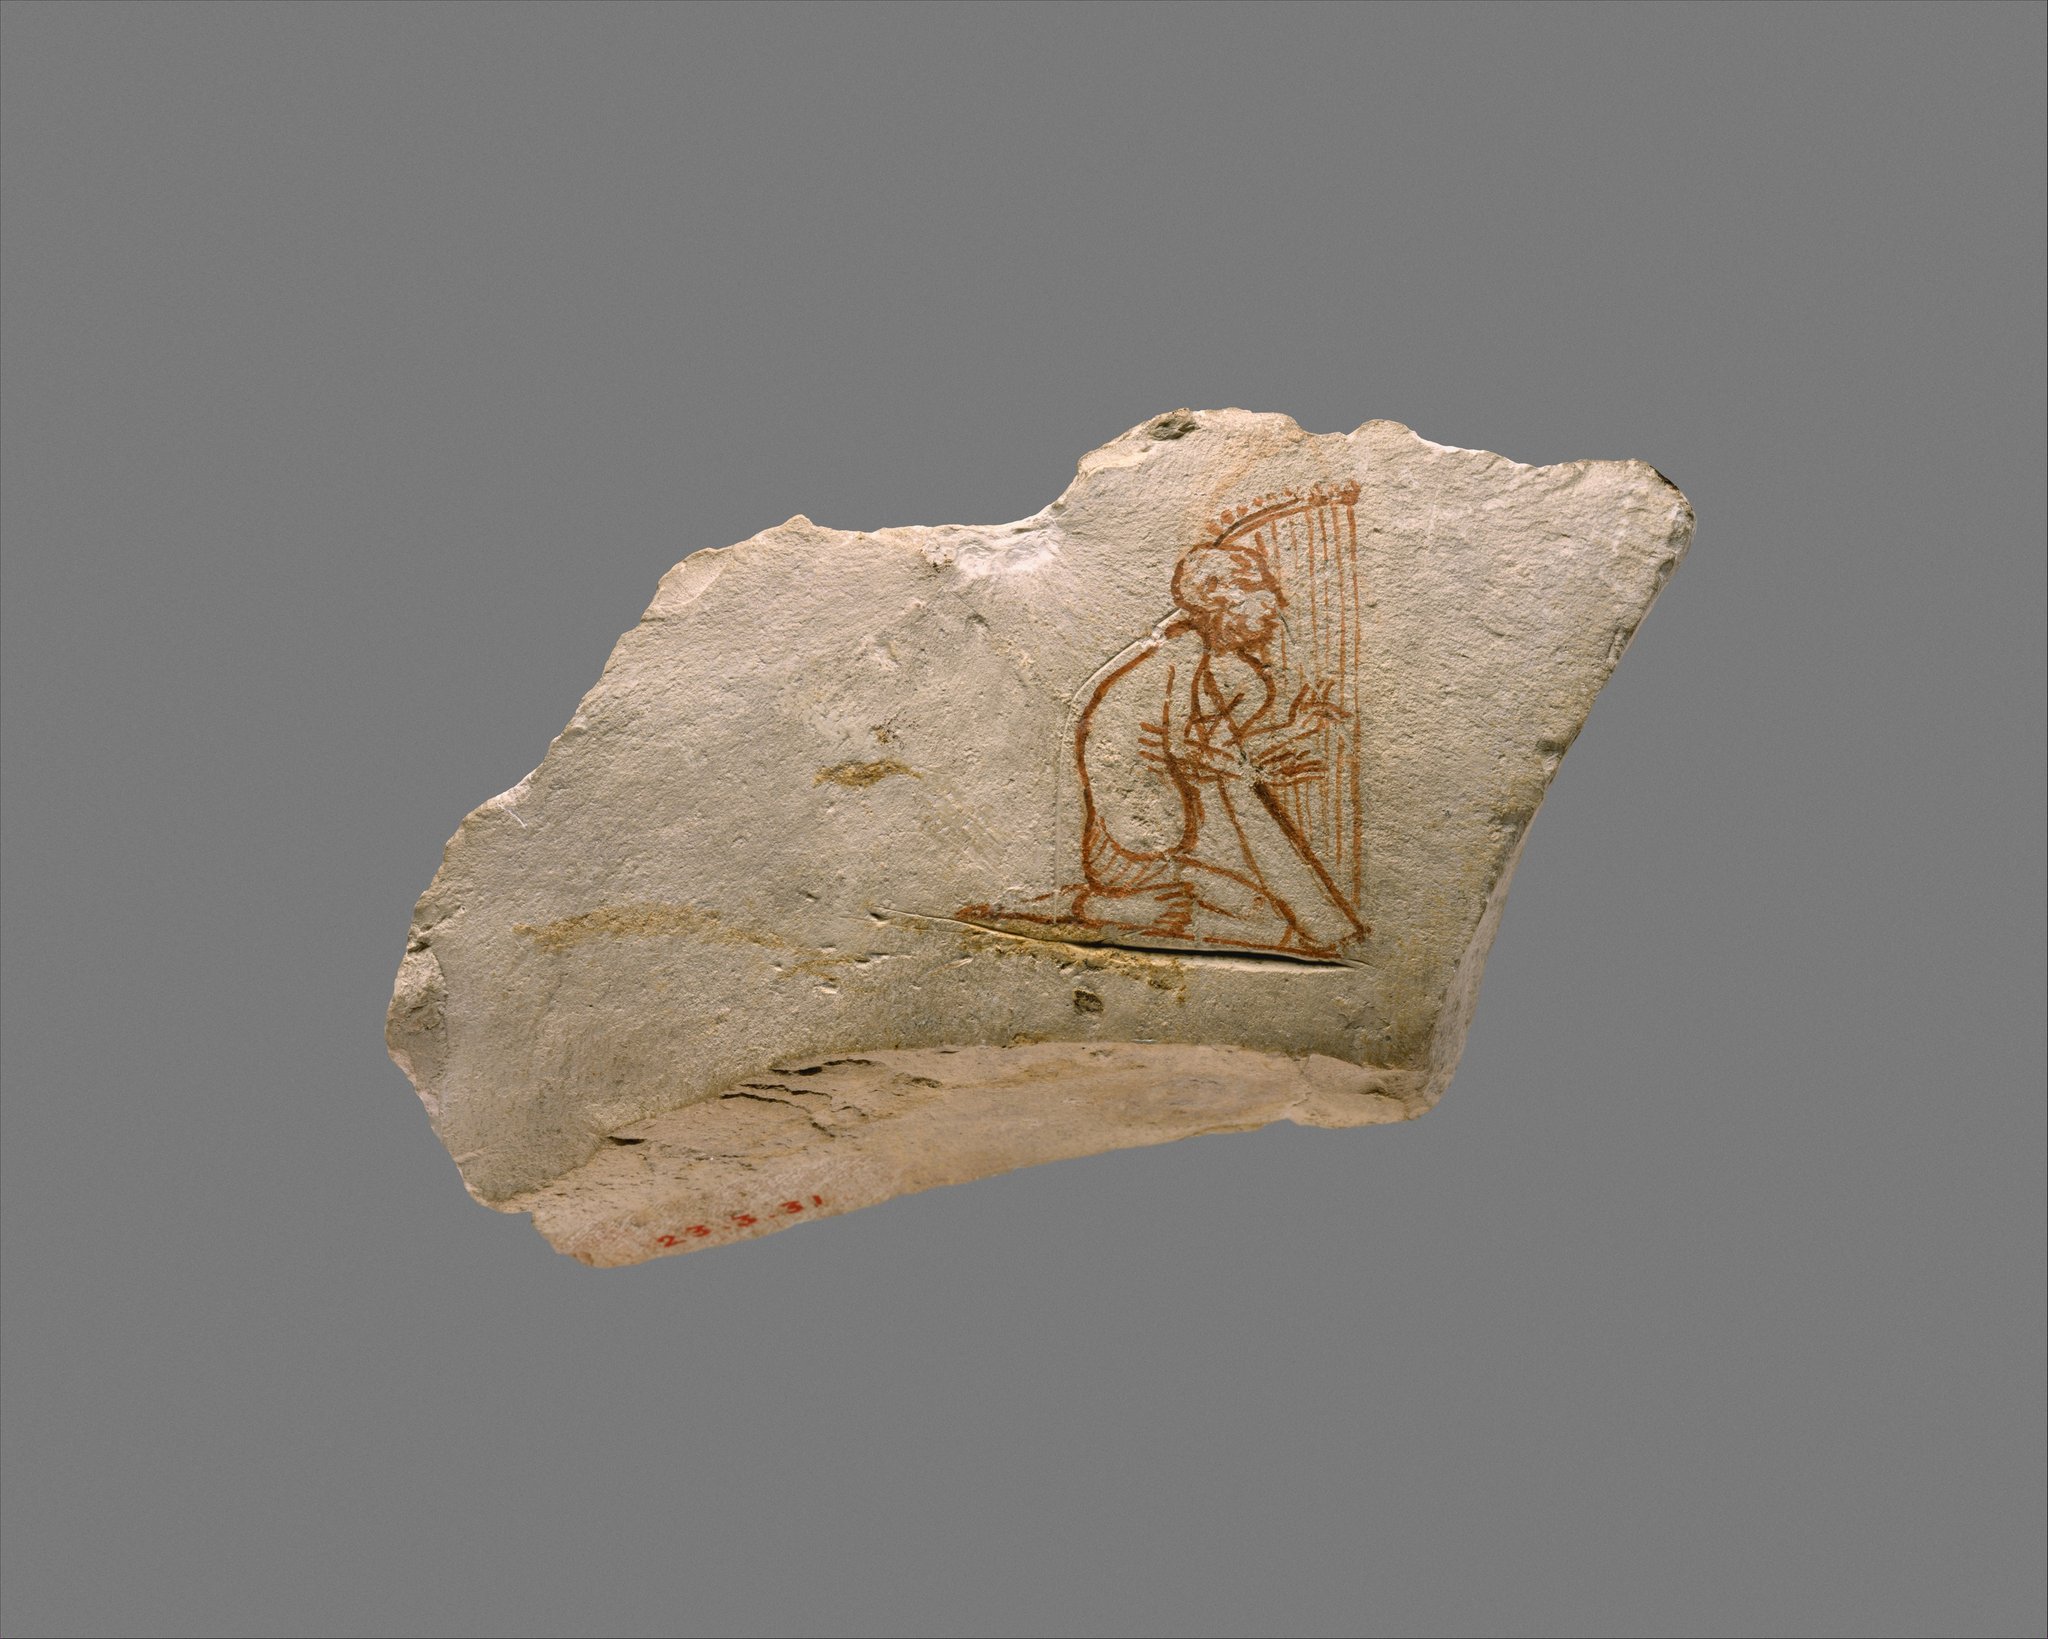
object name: ostracon, figured, harpist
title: Ostracon with sketch of a harpist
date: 664-610 BCE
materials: ink, limestone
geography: egypt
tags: men,harps,musicians